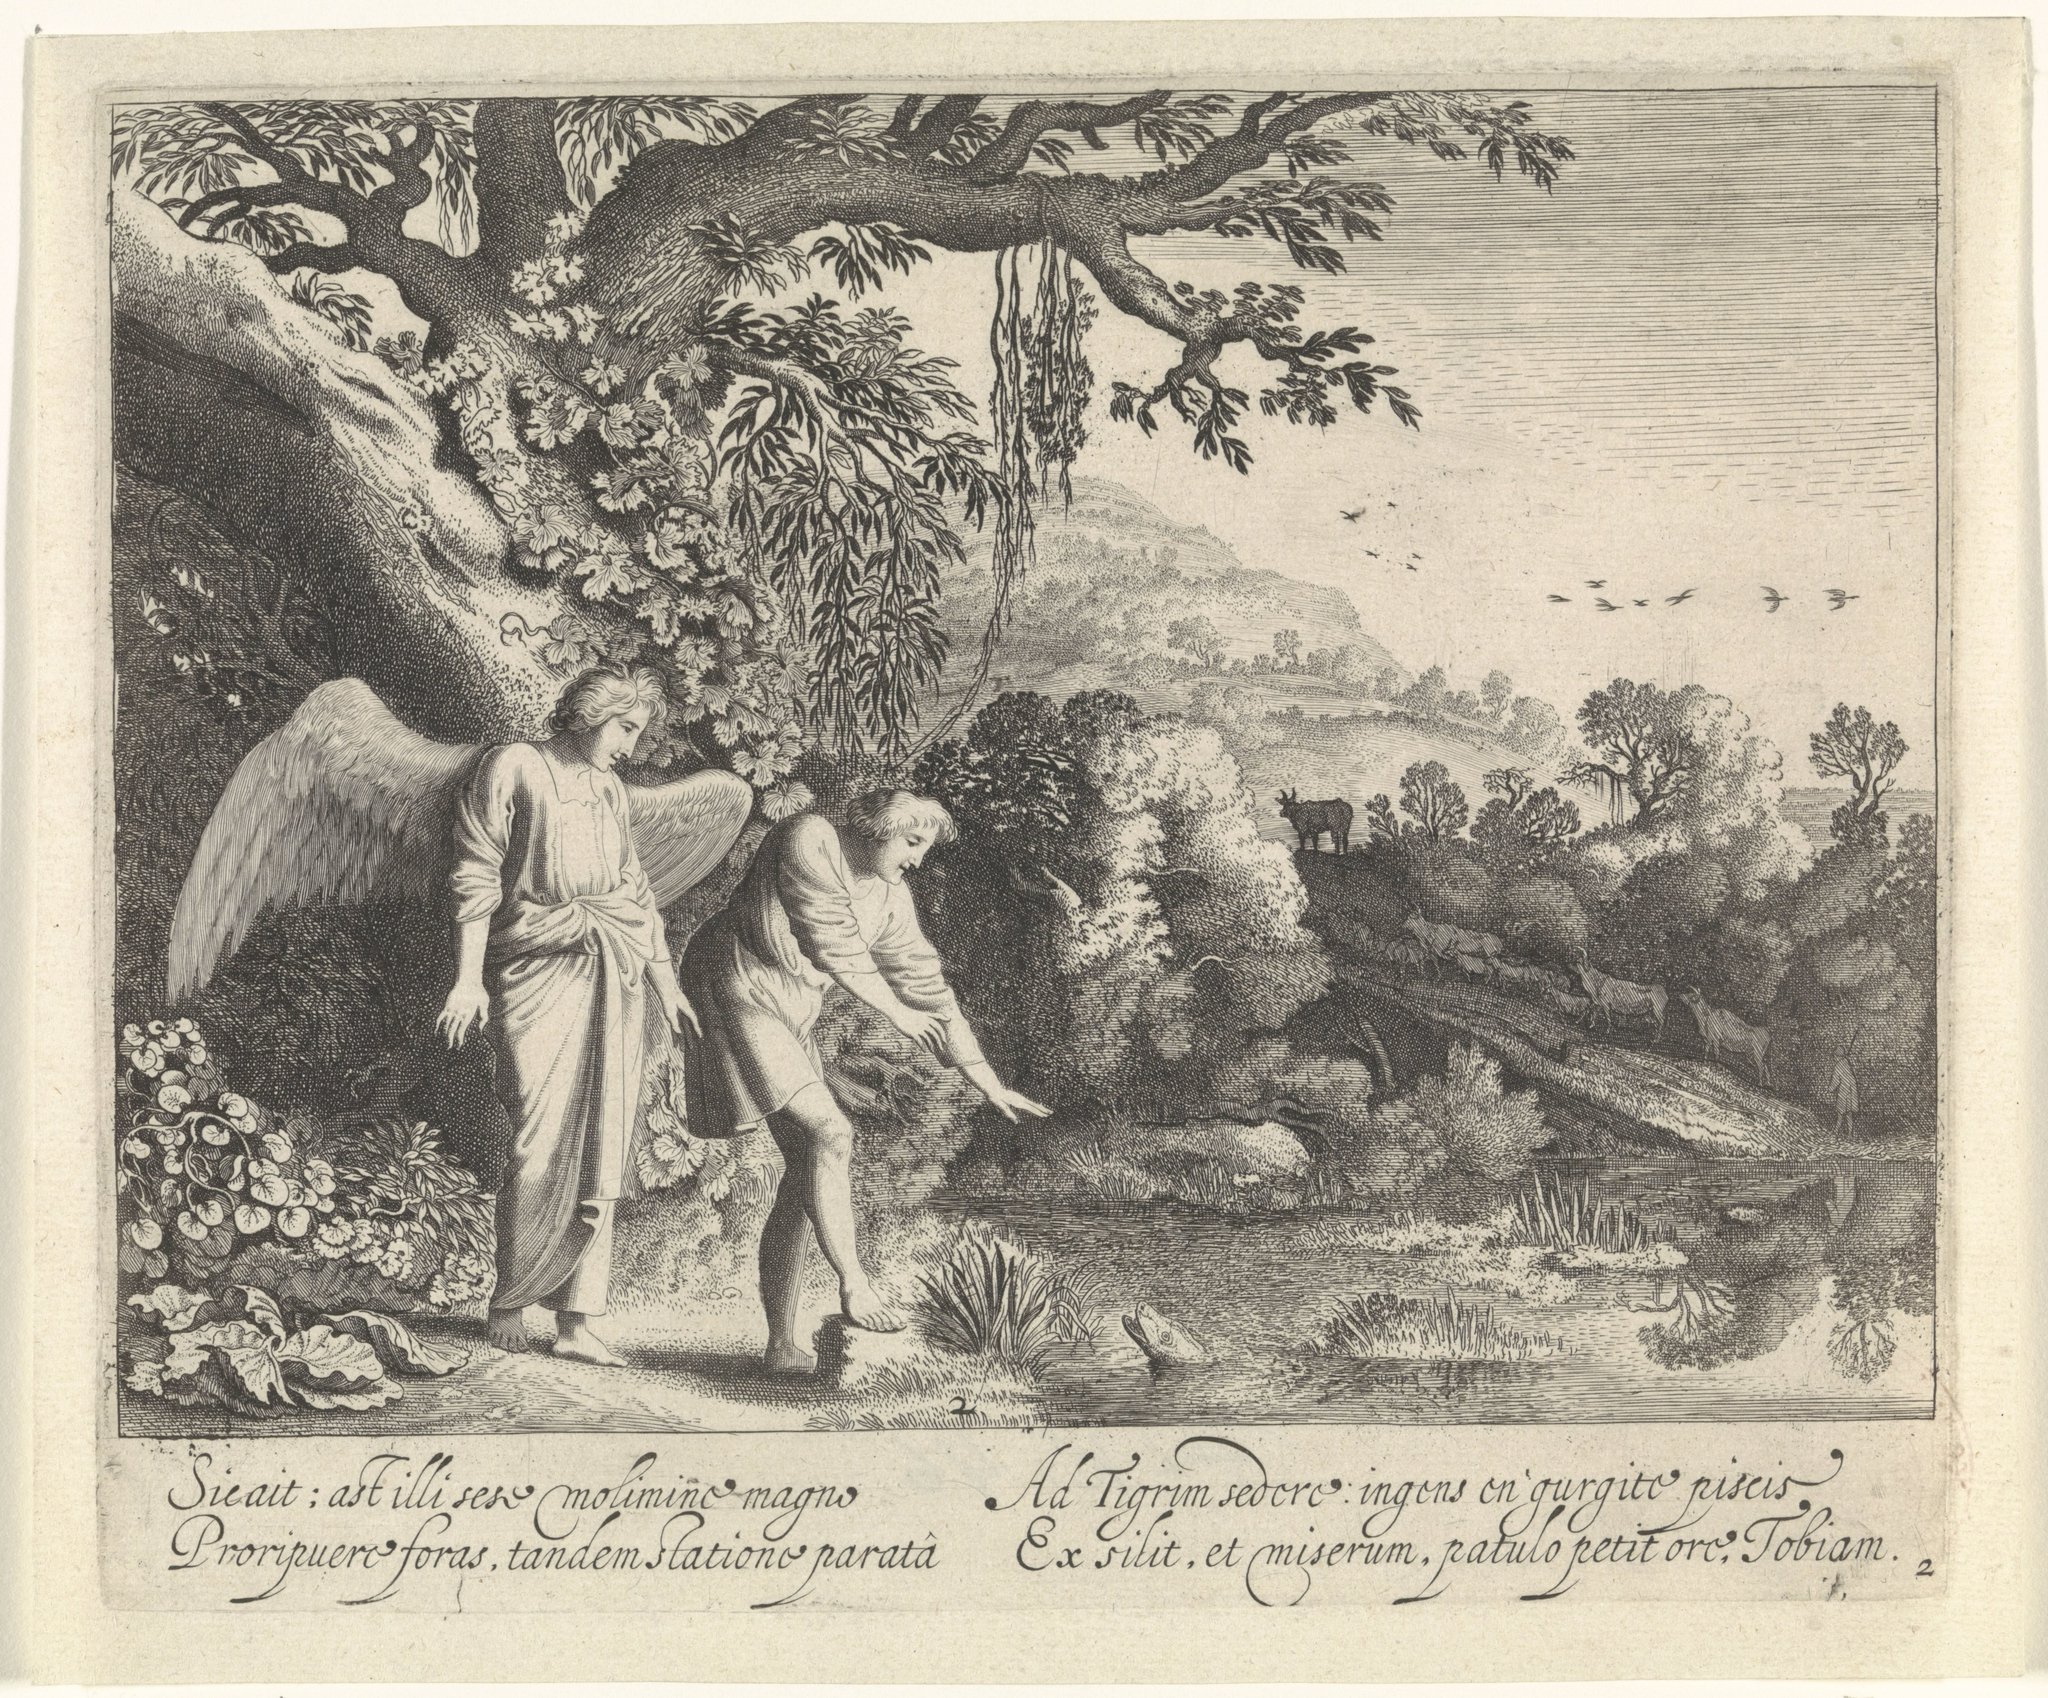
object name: print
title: Tobias bij de vis in de rivier de Tigris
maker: jan van de velde (ii)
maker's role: draughtsman, painter, print maker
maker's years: 1593-1641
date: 1603-1641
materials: paper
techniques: engraving, etching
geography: northern netherlands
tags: tobias washes his feet in the river tigris, a large fish appears while tobias is washing his feet; he is frightened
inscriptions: collector's mark: Lugt 240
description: Tobias wil zijn voeten wassen in de rivier de Tigris, waarop de engel Rafaël hem opdraagt de vis te vangen die verschijnt. Tweede prent uit een serie van vier over het bijbelverhaal van Tobias.